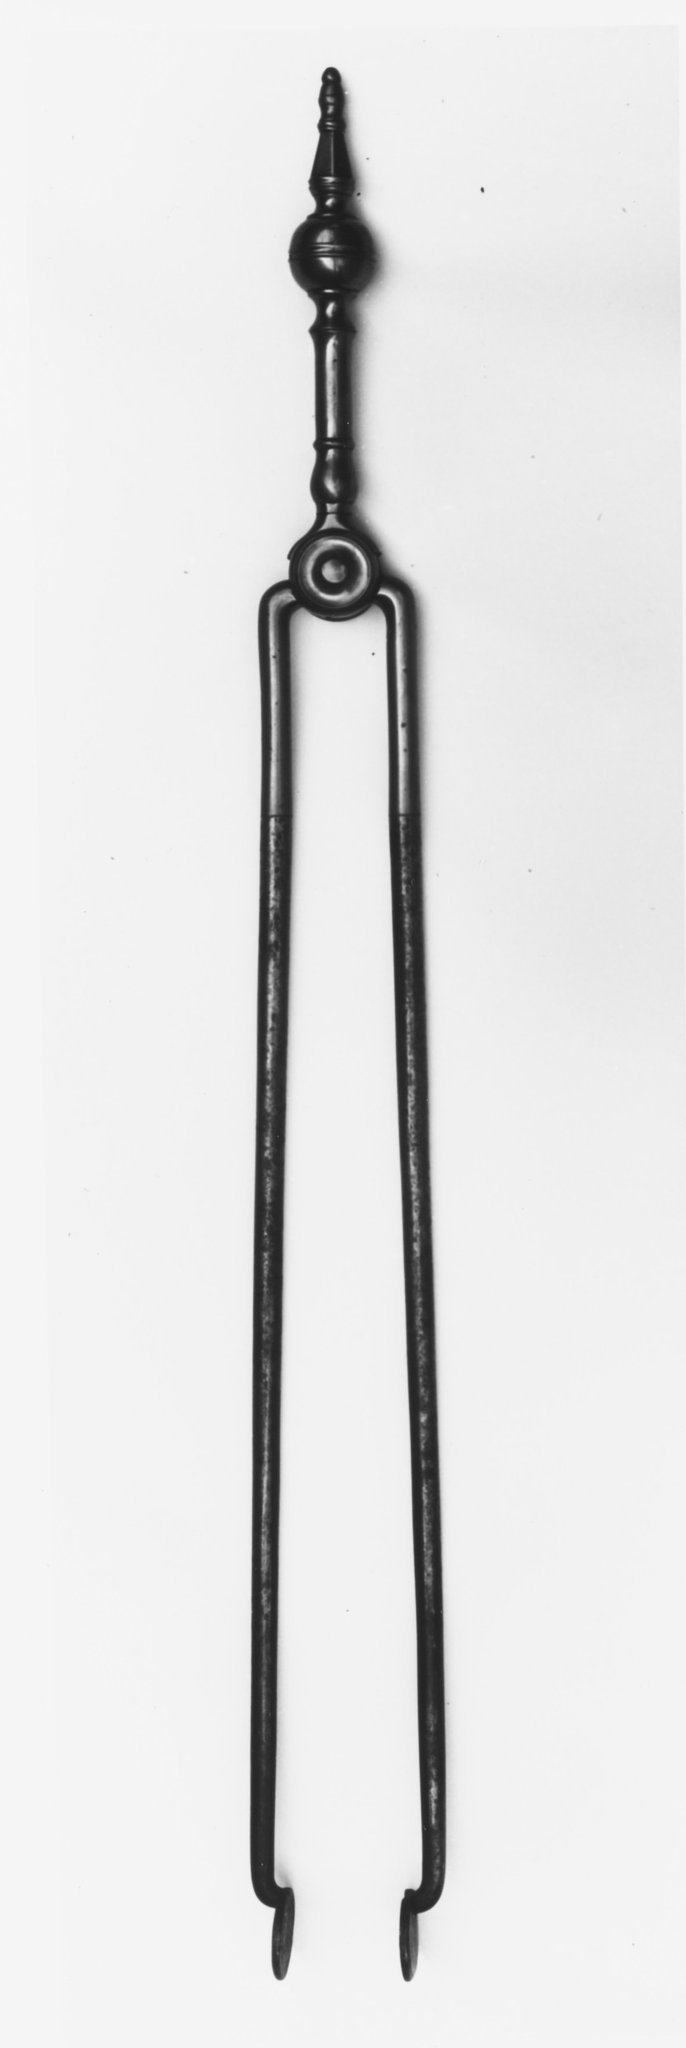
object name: fire tongs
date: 1770-1830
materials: brass, steel